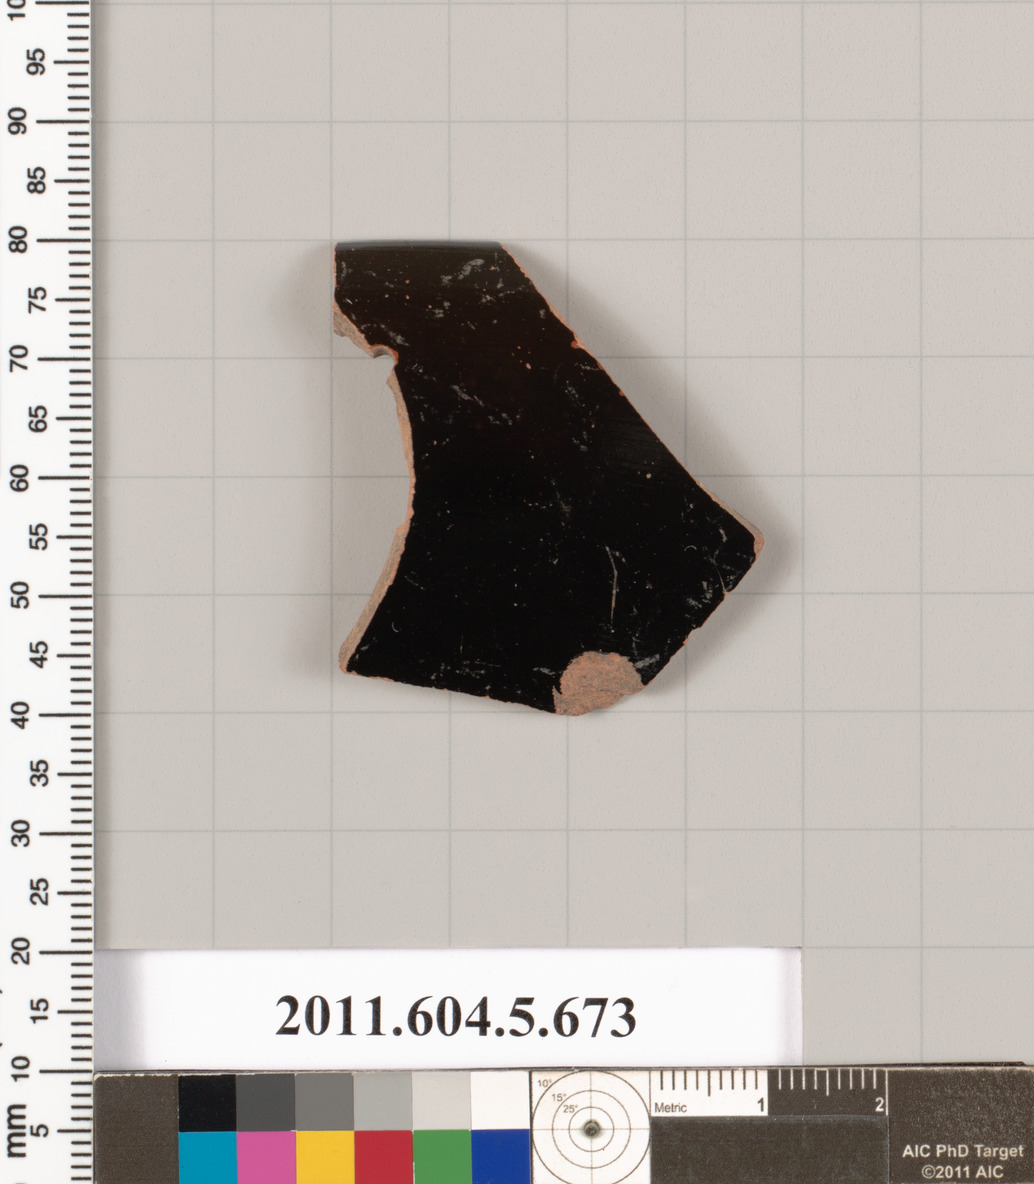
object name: kylix fragment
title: Terracotta rim fragment of a kylix (drinking cup)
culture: greek, attic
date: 600-401 BCE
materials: terracotta